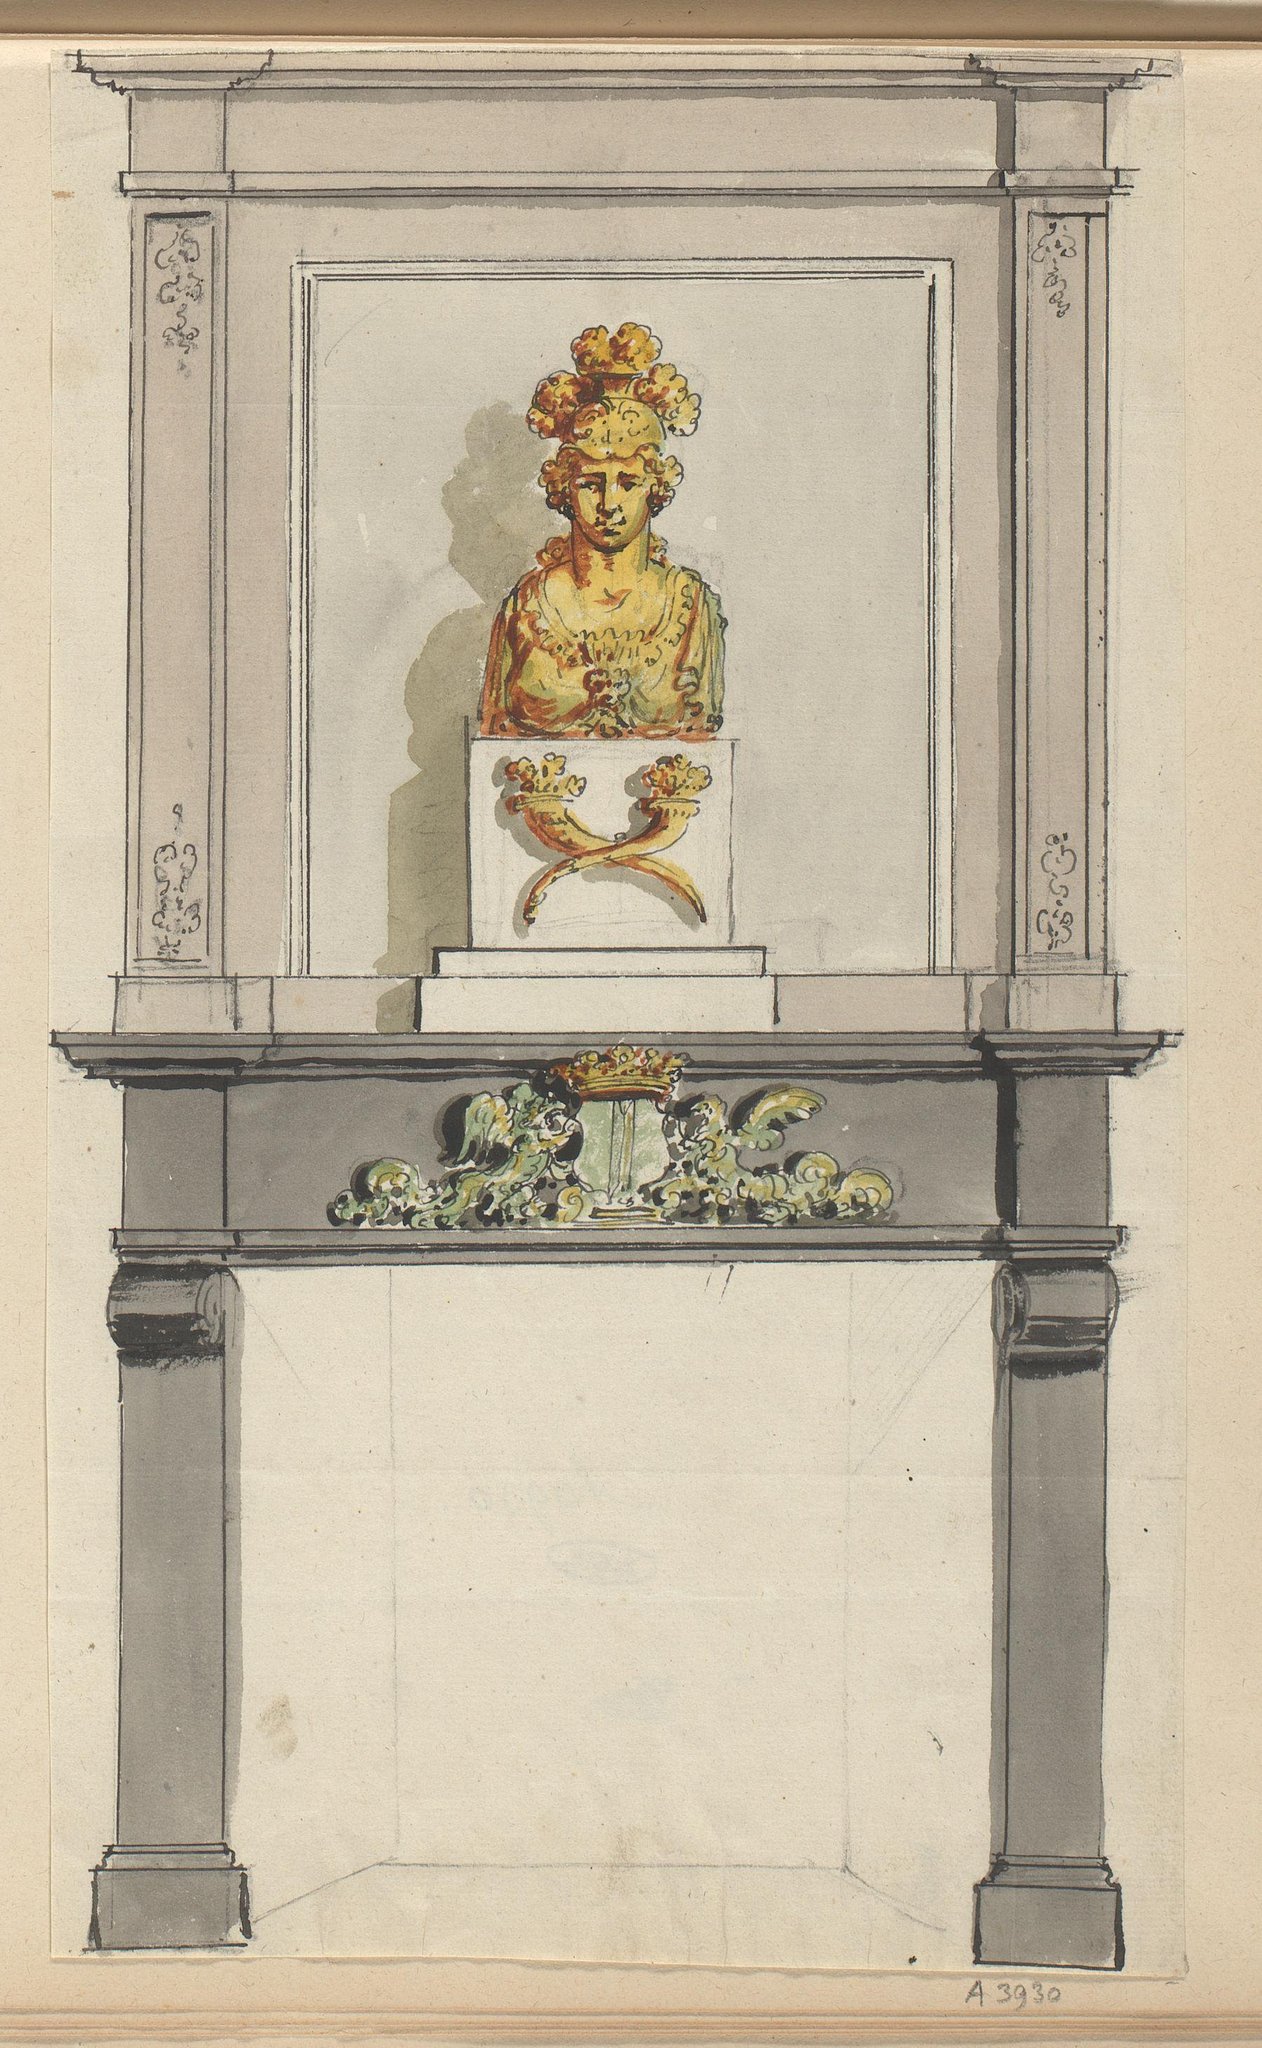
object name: album leaf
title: Ontwerptekening voor een schouw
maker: abraham van strij (i)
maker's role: draughtsman, painter, print maker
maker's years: 1753-1826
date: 1763-1826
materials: paint, paper, pencil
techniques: brush, pen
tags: (story of) minerva (pallas, athena), piece of sculpture, reproduction of a piece of sculpture, chimney-piece, mantelpiece, armorial bearing, heraldry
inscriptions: collector's mark: Lugt 2228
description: De tekeningen van Abraham van Strij zijn op een later moment ingevoegd in het album met tekeningen van Jurriaan Andriessen.